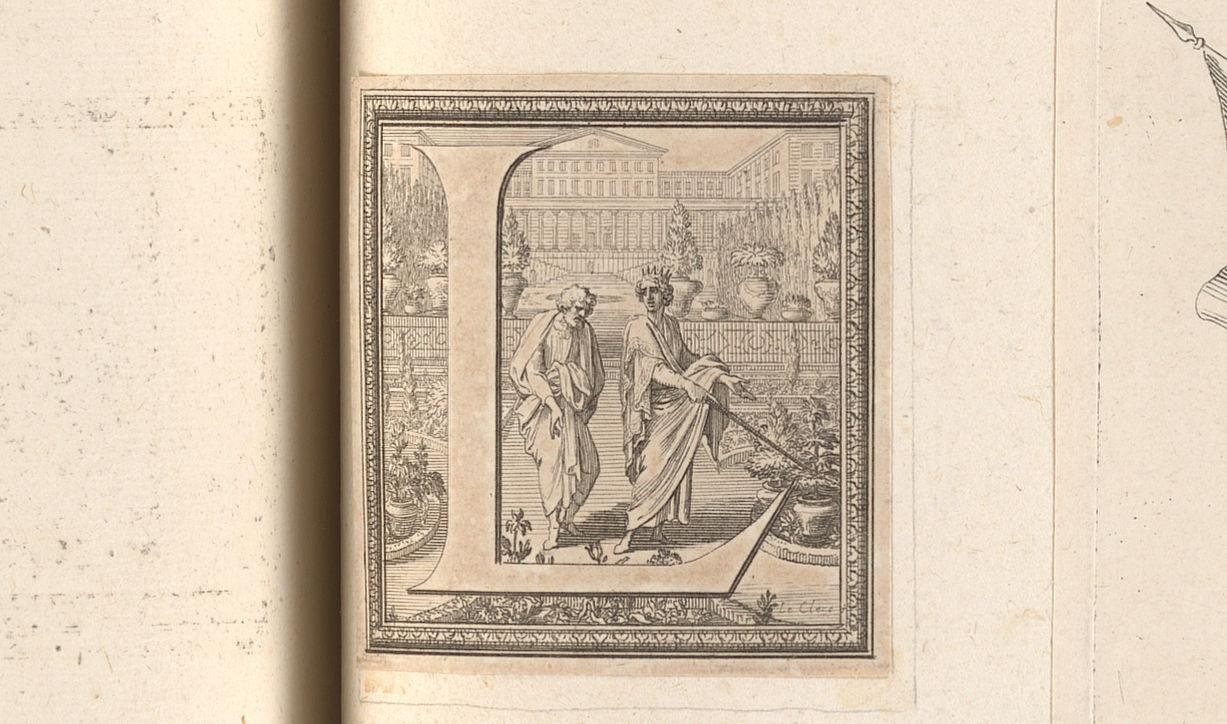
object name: book illustration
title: Initiaal 'L' met twee figuren in een tuin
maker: sébastien leclerc (i)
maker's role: print maker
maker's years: 1637-1714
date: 1676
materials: paper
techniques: etching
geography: paris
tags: initial, garden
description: Prent uit: Dodart, Denis. Mémoires pour servir à l'histoire des plantes (...). Parijs: Imprimerie Royale, 1676.